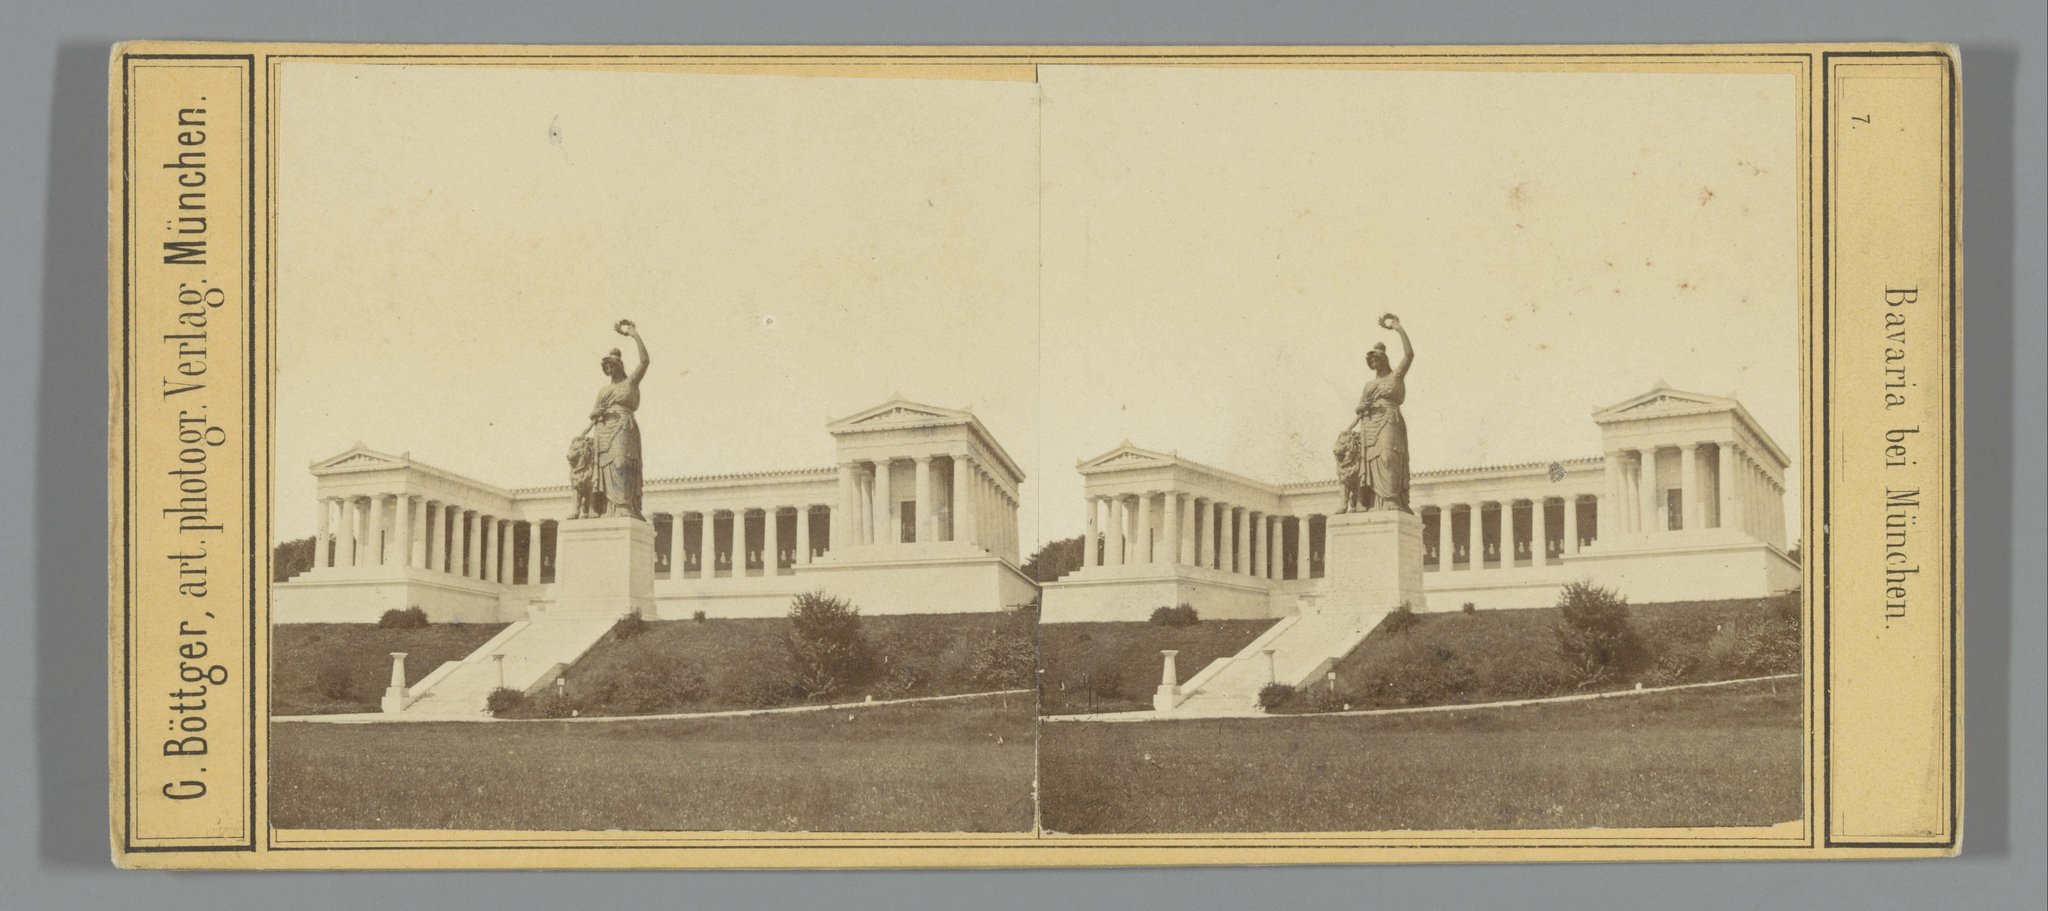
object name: stereograph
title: Bavaria bei München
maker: georg böttger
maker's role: fotograaf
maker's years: 1821-1902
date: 1870-1885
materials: cardboard, photographic support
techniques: albumen print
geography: munich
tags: sculpture, façade (of house or building)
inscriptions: number: ‘G. 4.’, number: ‘7.’